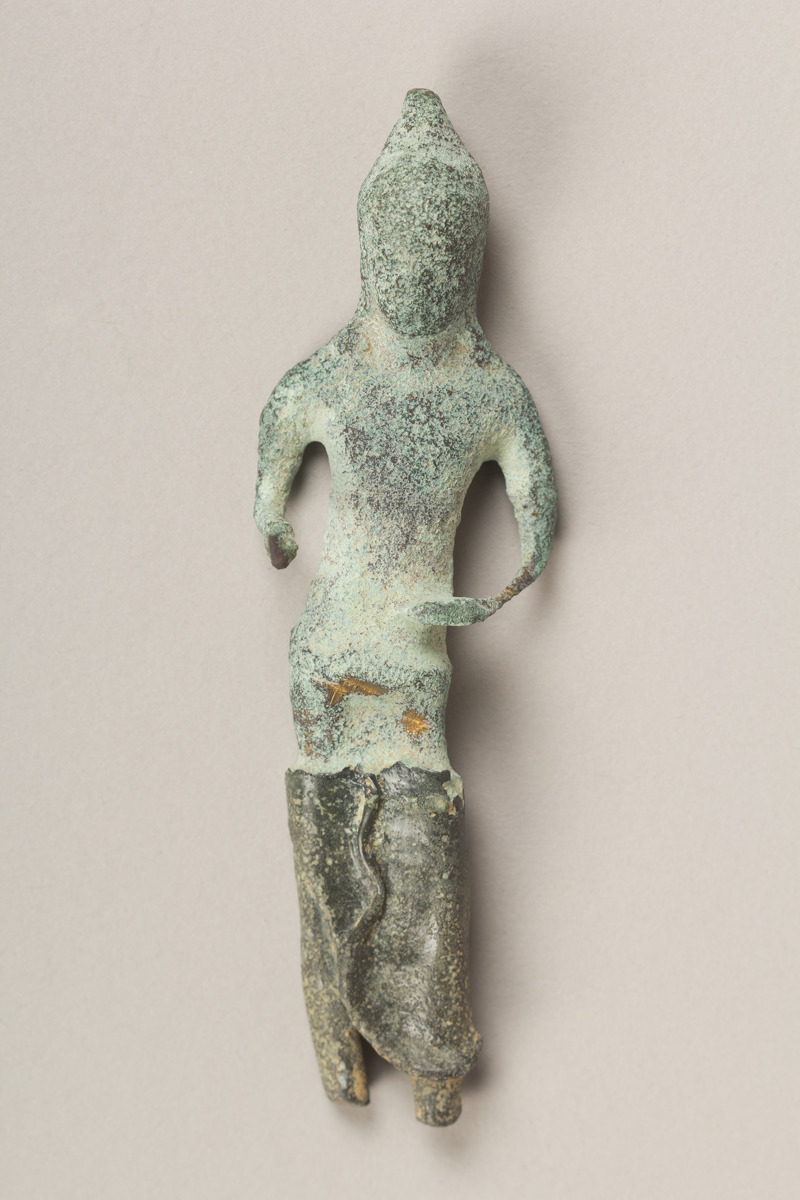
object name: figure fragment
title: Fragment of a Standing Figure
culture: indonesian, kalimantan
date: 701-800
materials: bronze